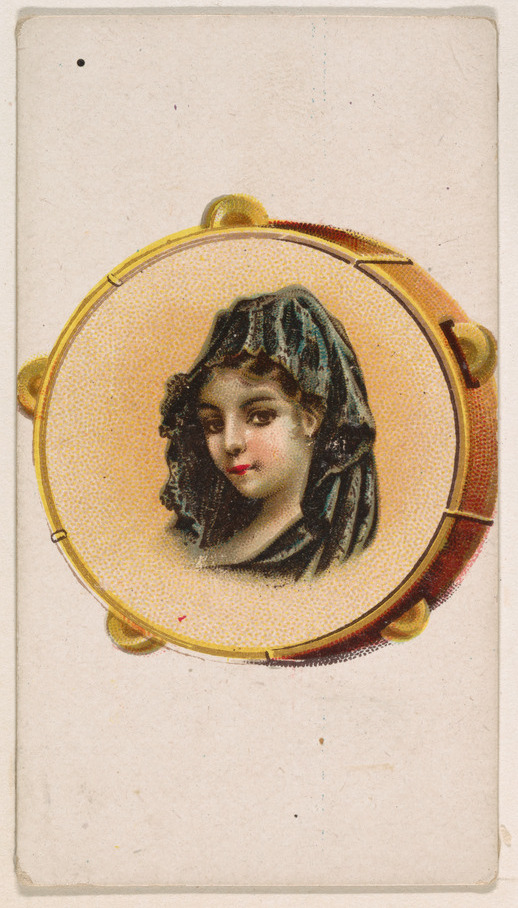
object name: print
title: Tambourine, from the Novelties series (N228, Type 5) issued by Kinney Bros.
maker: kinney brothers tobacco company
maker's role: publisher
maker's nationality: american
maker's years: 1869-2011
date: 1889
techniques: color lithograph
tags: women